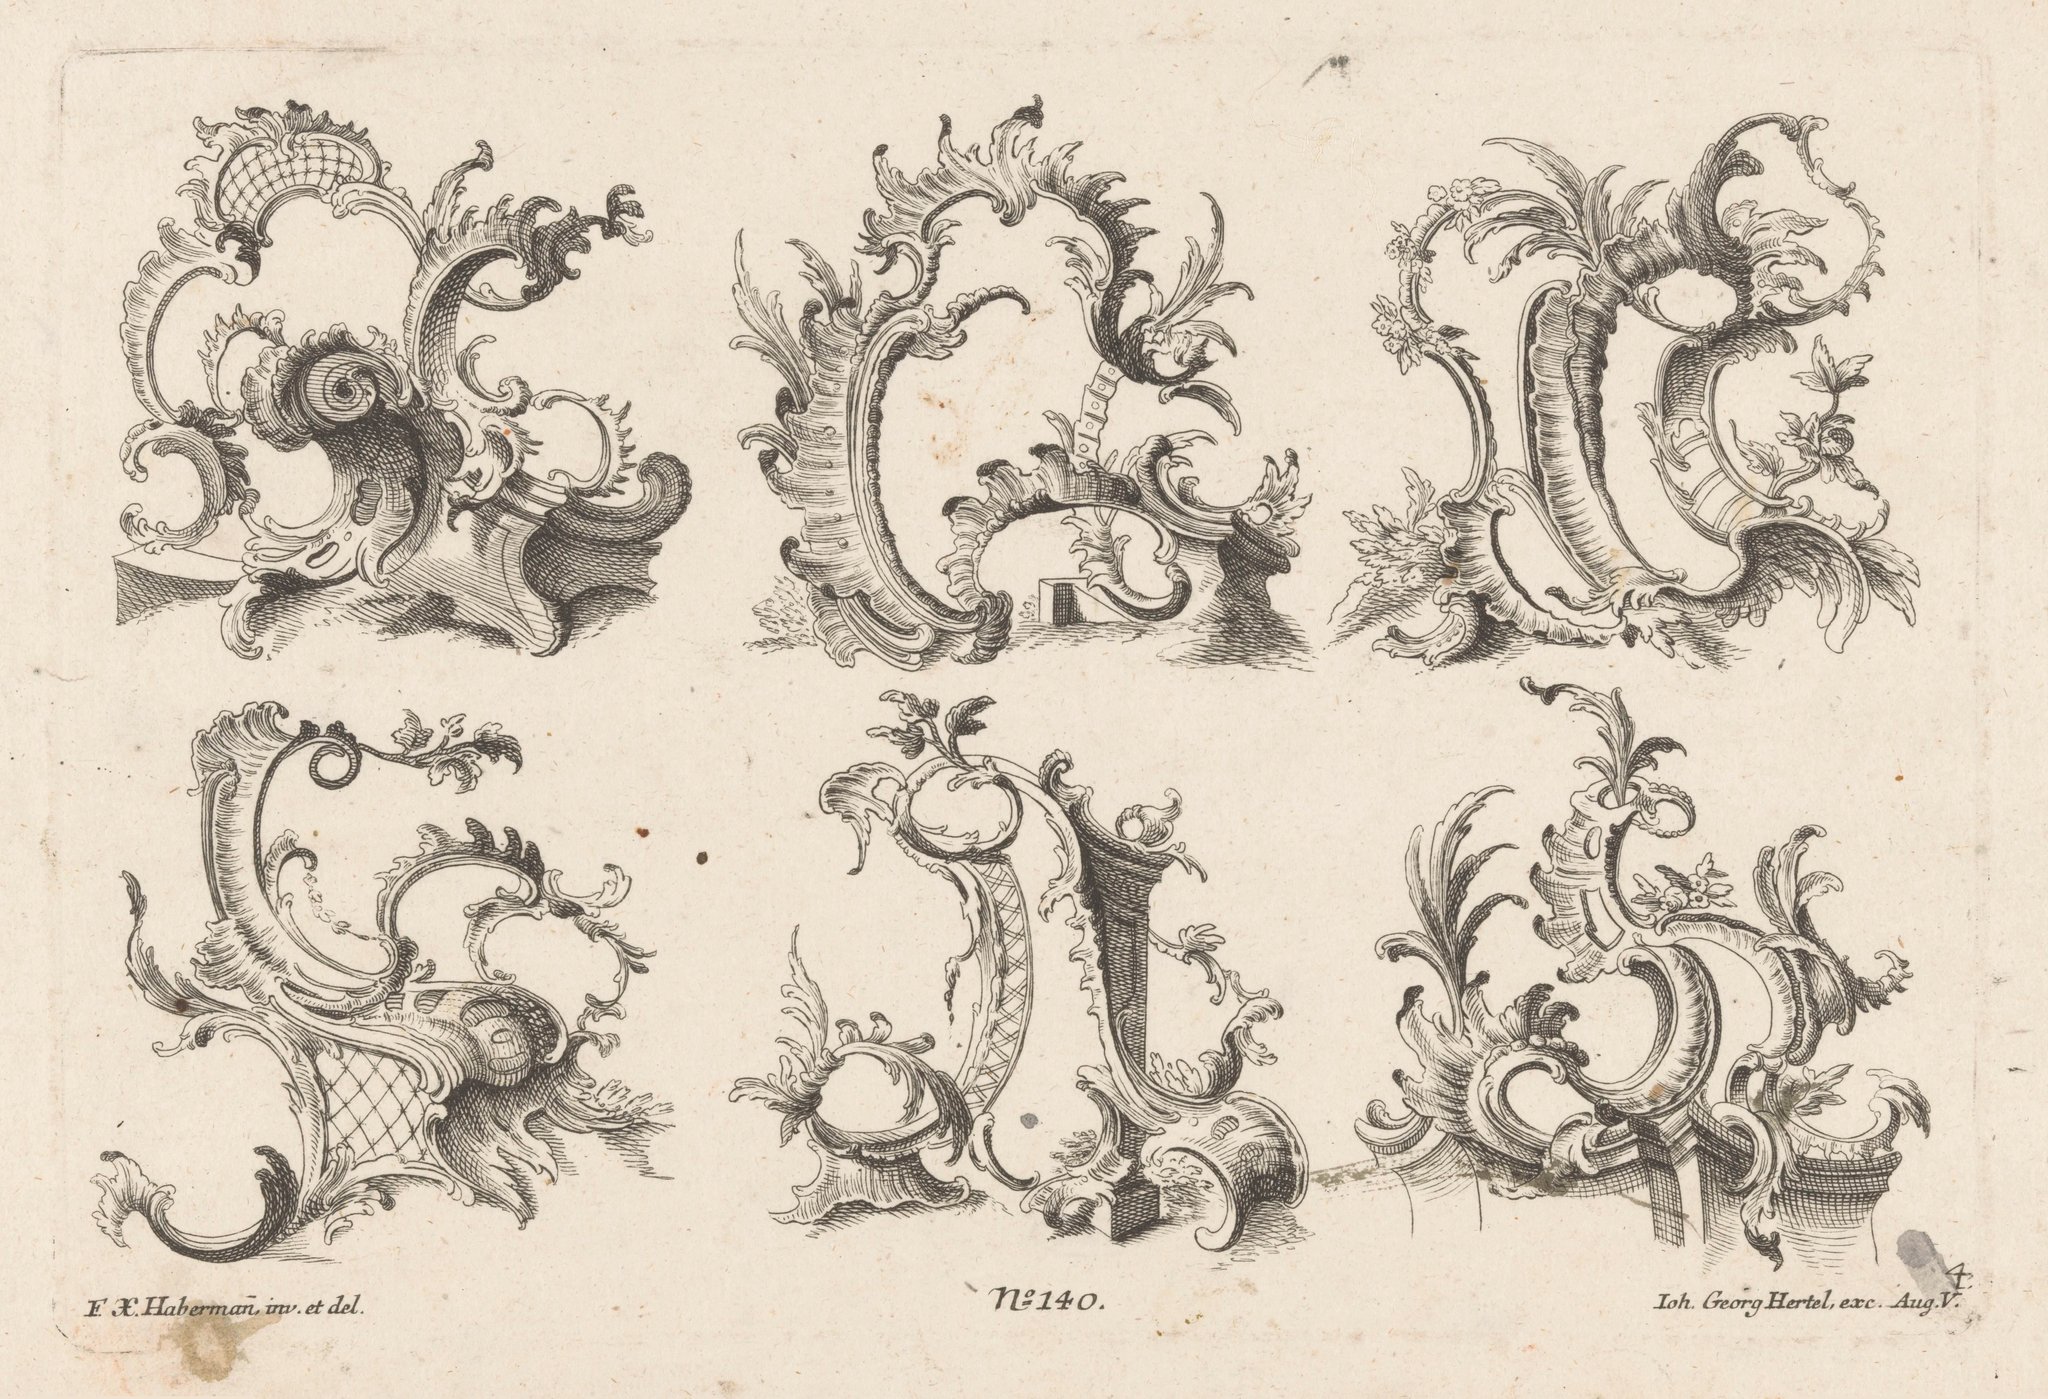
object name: ornament print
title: Rocailles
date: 1731-1775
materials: paper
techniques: etching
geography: augsburg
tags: rocaille ornament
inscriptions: watermark, collector's mark: Lugt 2228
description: Zes rocaille ornamenten. Uitgeversnummer 140.